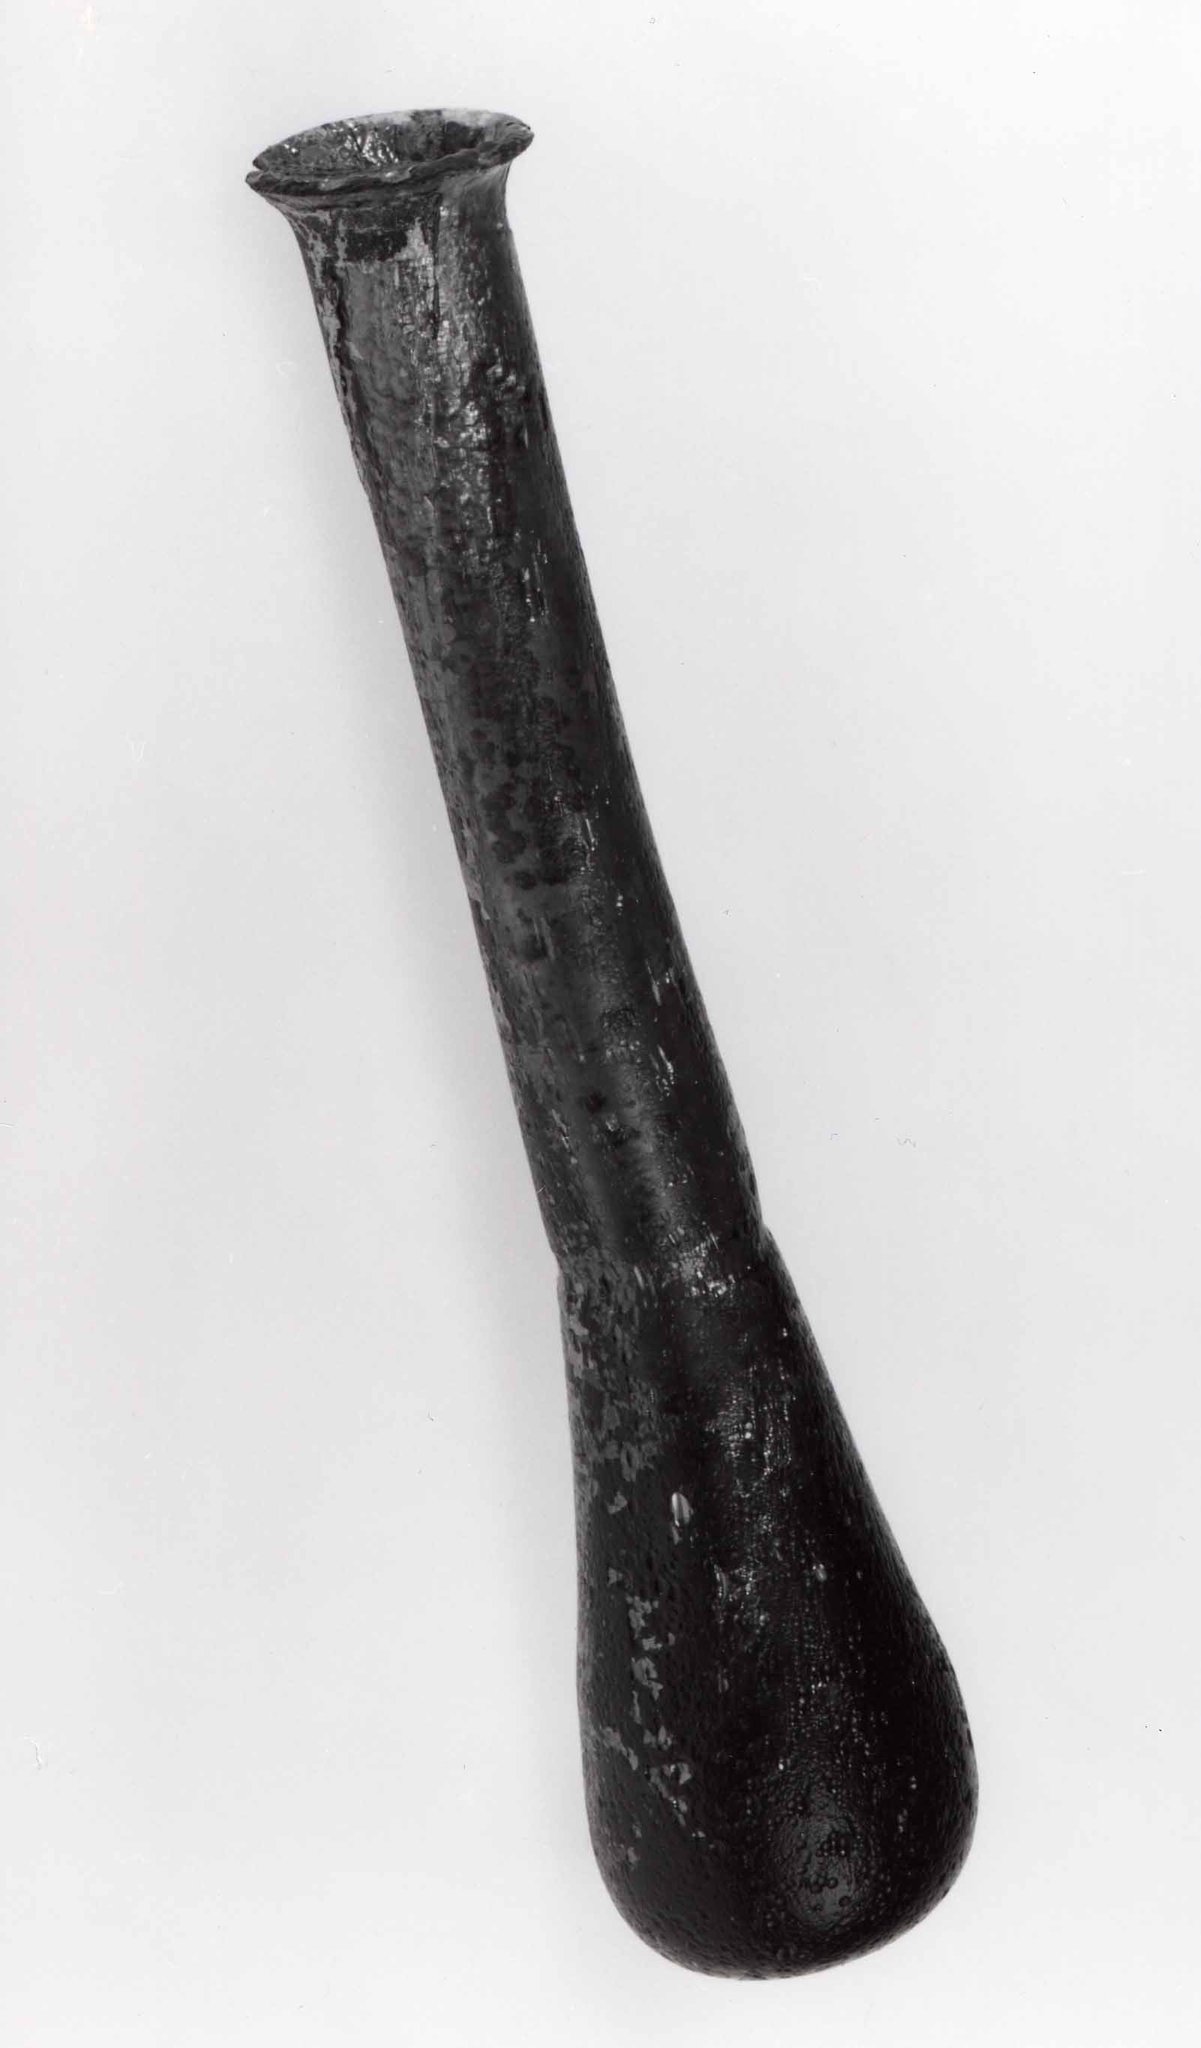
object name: toilet bottle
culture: roman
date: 34-200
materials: glass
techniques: glassblowing